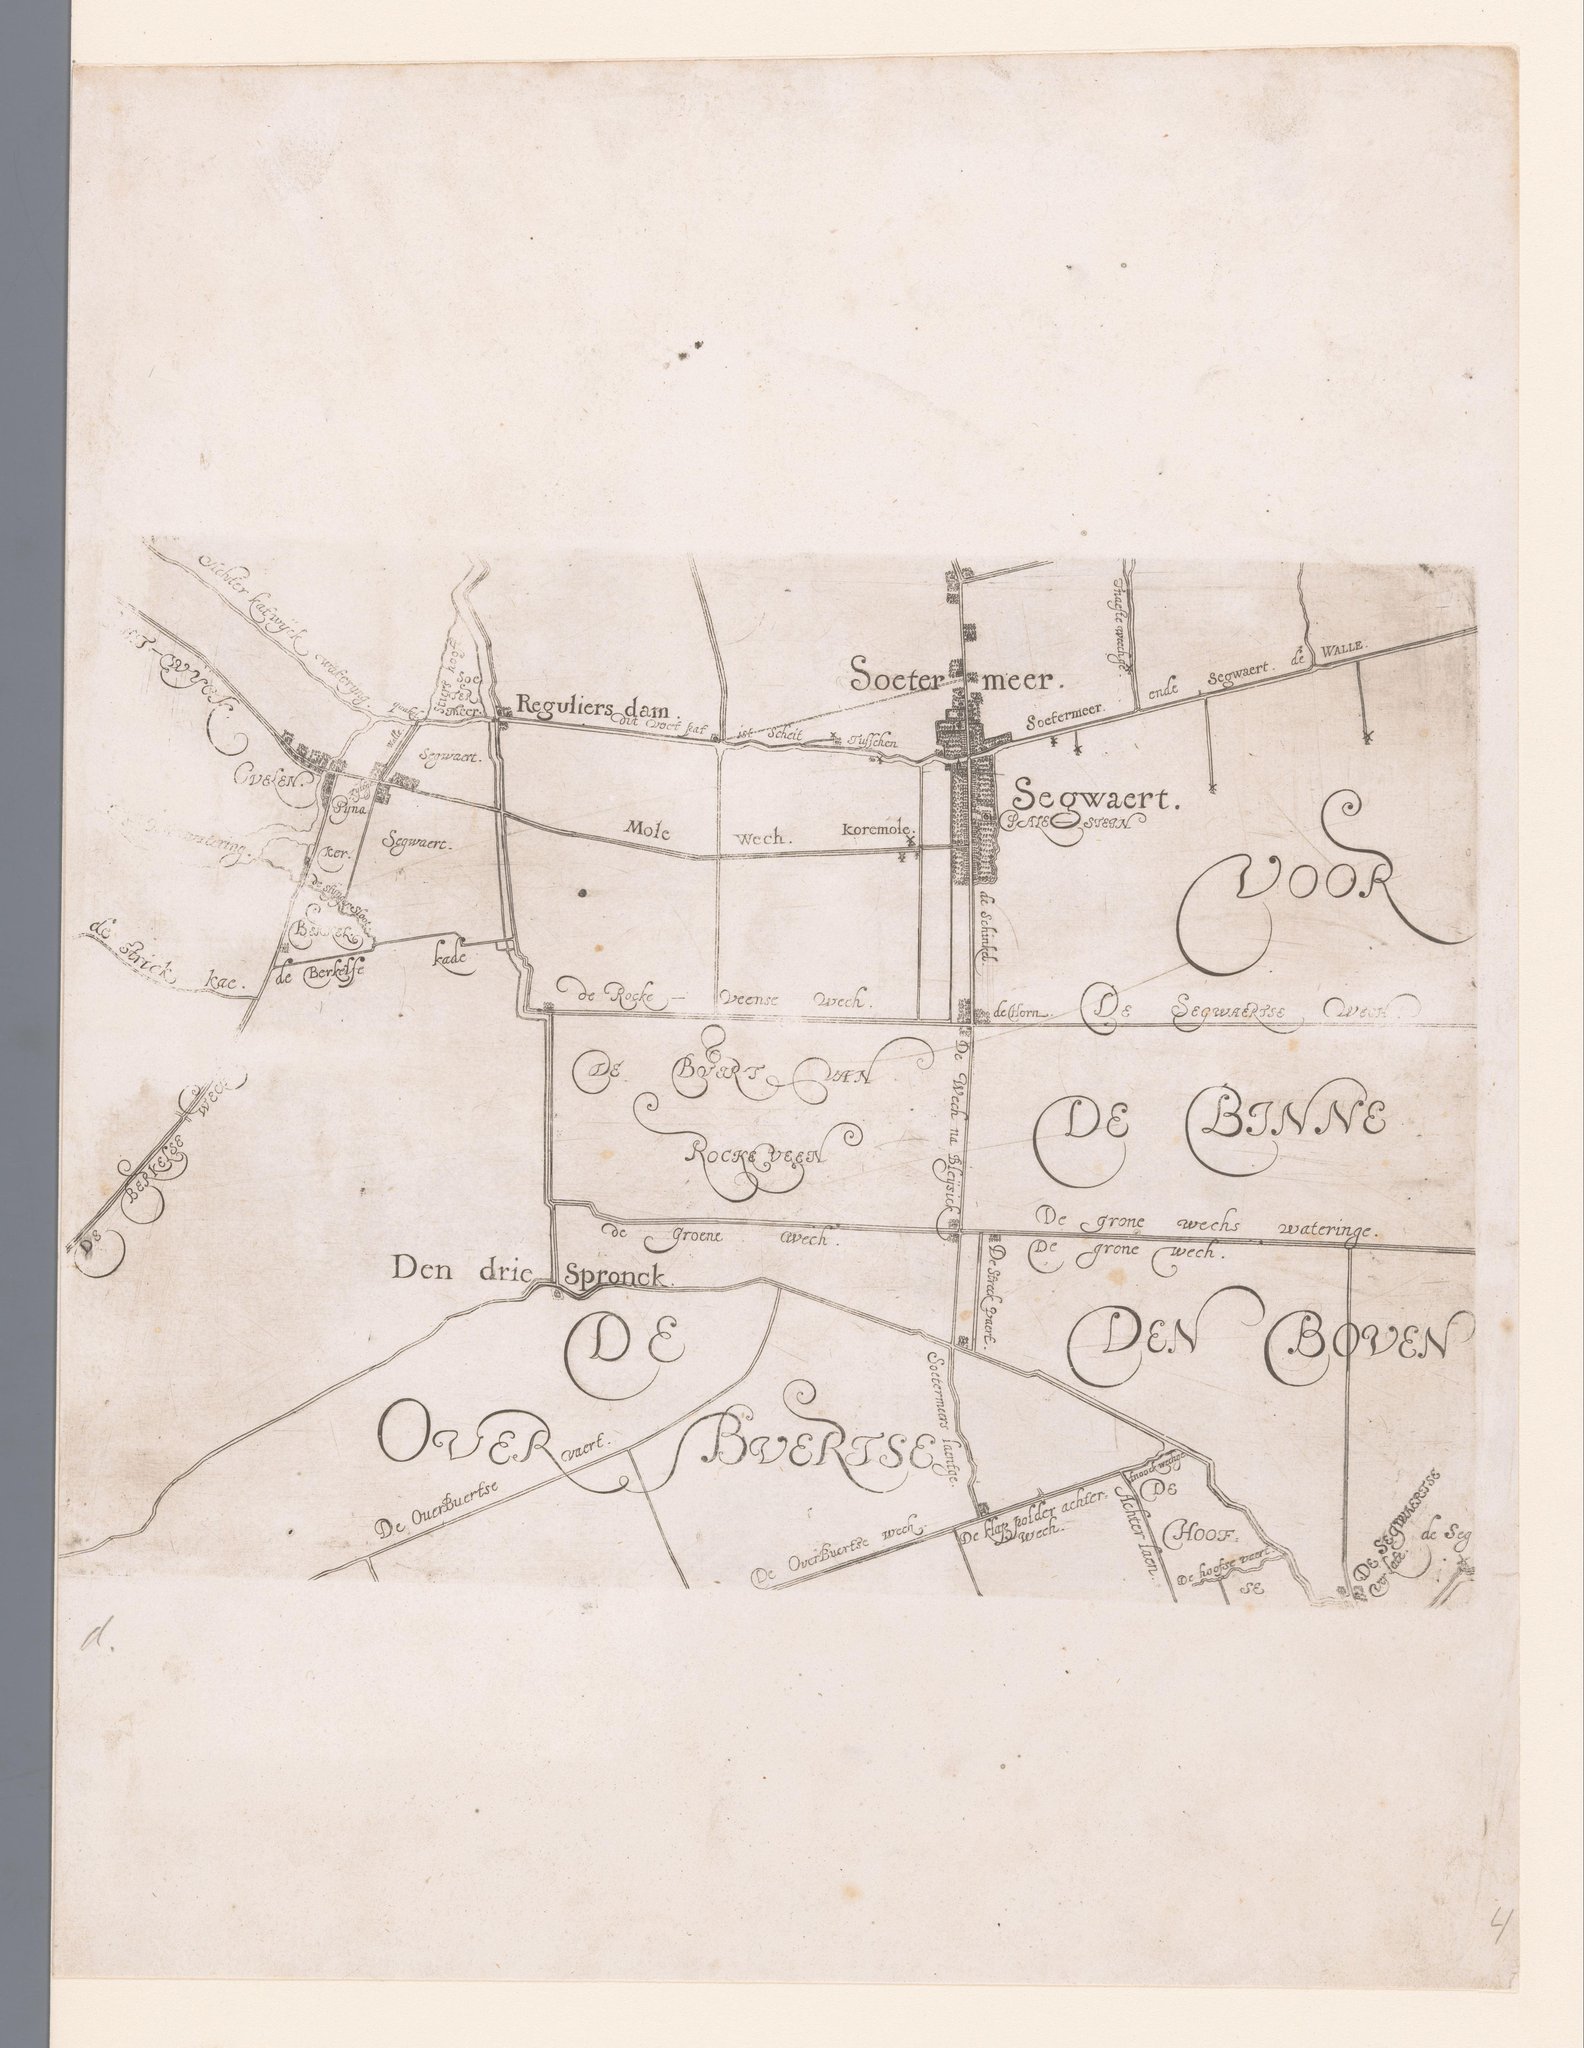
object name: print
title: Kaart van het Hoogheemraadschap van Schieland, met Zoetermeer en Seghwaert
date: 1611-1635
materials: paper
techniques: engraving, etching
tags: maps of separate countries or regions, armorial bearing, heraldry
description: Deze kaart is tussen 1611 en 1635 vijf keer uitgegeven zonder dat de platen zijn bijgewerkt. Onduidelijk tot welke uitgave dit exemplaar behoort.